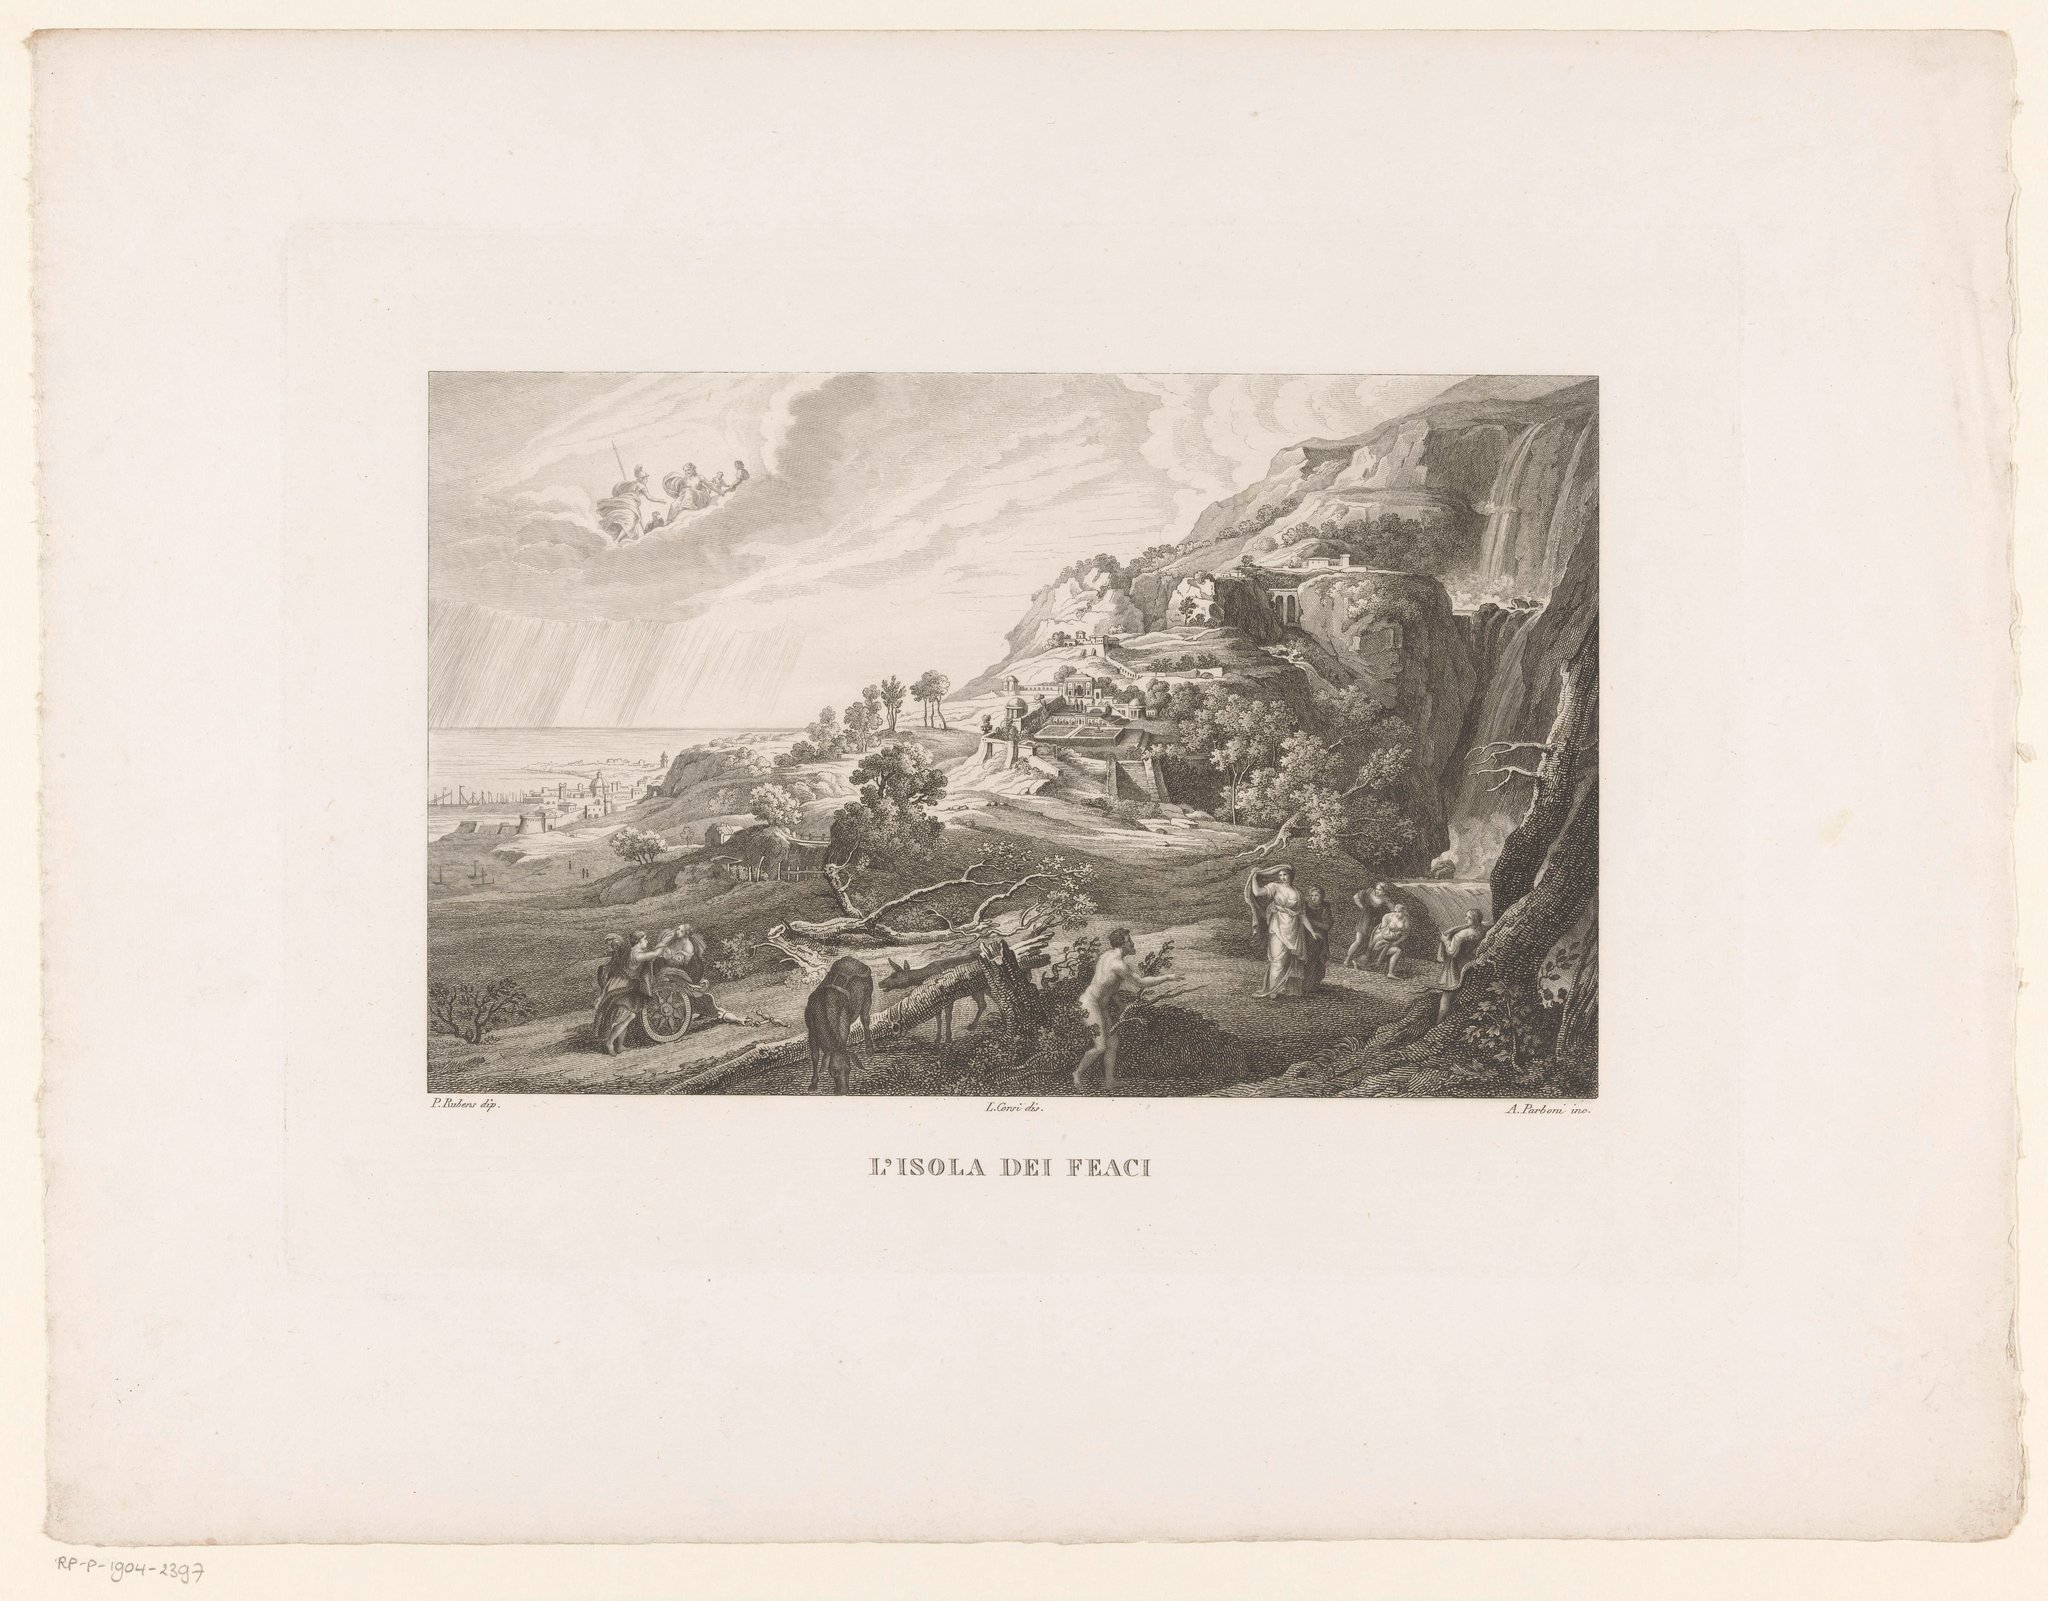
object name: print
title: Landschappen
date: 1800-1899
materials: paper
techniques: etching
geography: italy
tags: landscapes, the (nude) human figure; 'corpo humano' (ripa), (story of) ulysses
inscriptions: collector's mark: Lugt 2228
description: Gezicht op het eiland van de Feniciërs. Op de voorgrond Odysseus die naakt tussen de struiken staat. Links twee vrouwen bij een ruituig. Rechts een groep vrouwen bij een waterval. De vrouwen kijken geschrokken om naar Odysseus. Tussen de wolken zit een groep goden.